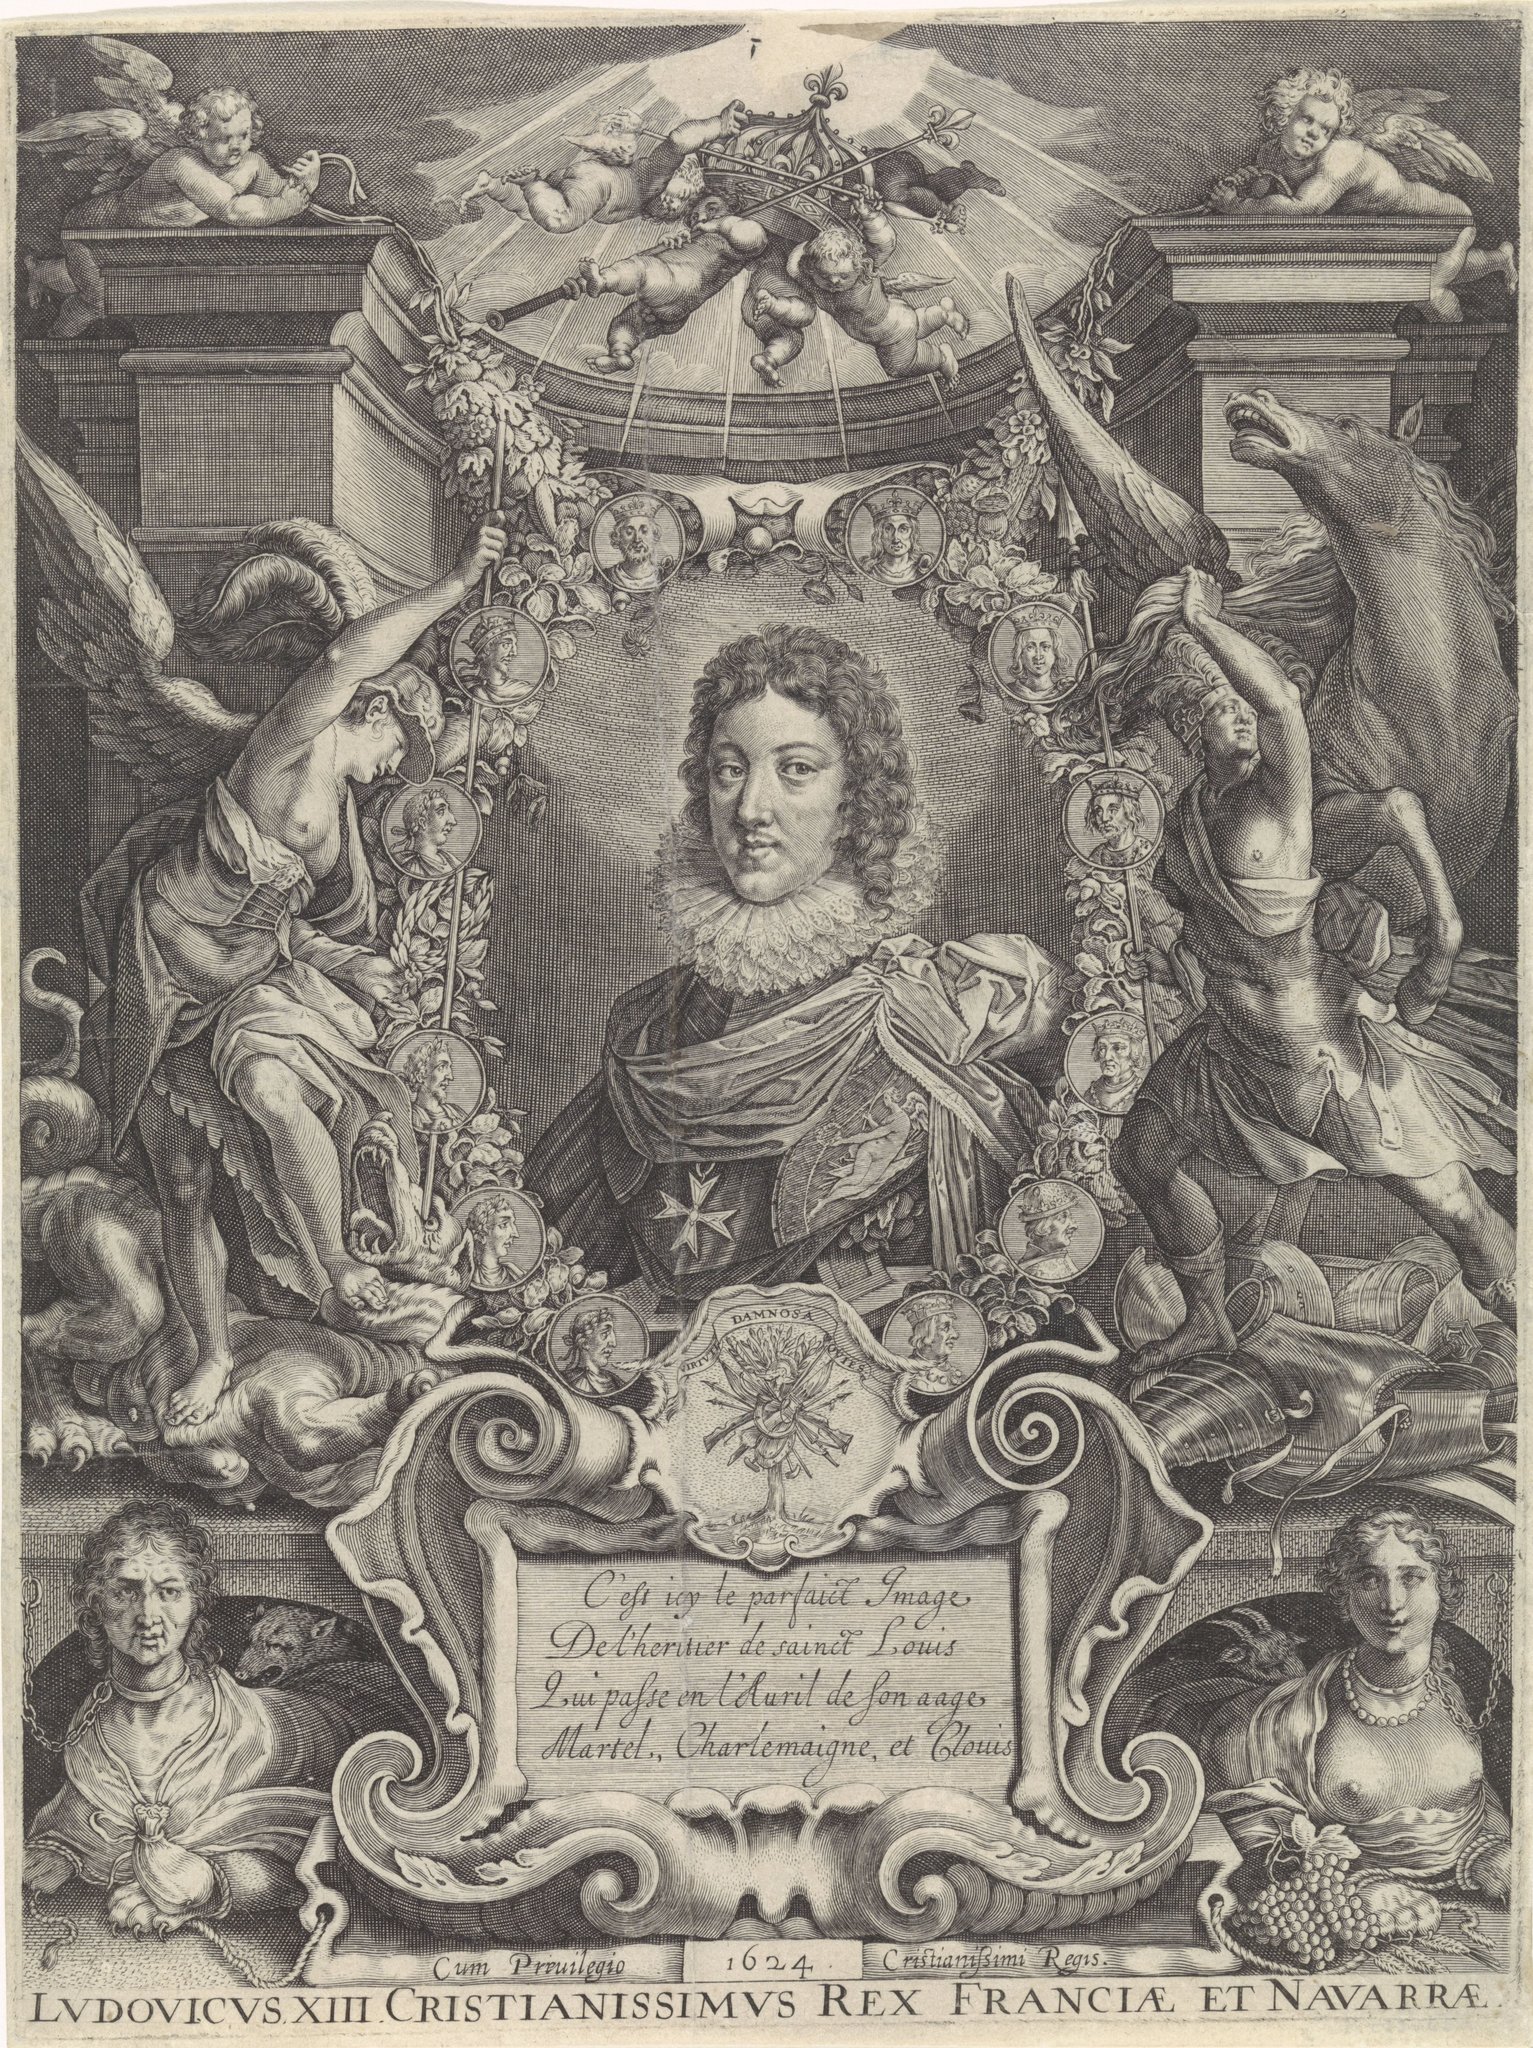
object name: print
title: Busteportret van Lodewijk XIII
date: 1624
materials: paper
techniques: engraving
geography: paris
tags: lodewijk xiii (koning van frankrijk), pegasus, the winged horse, crown (symbol of sovereignty), the archangel michael (often in armour with sword or lance), knighthood order of the holy spirit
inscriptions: date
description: Busteportret van Lodewijk XIII, koning van Frankrijk. Hij draagt een Ordeketting van de Orde van de Heilige Geest. Zijn portret is gevat in een omlijsting met de portretten van zijn voorgangers en zijn wapenschild met zijn devies in het Latijn. Het portret wordt geflankeerd door de aartsengel Michaël die in gevecht is met de draak en een Romeinse soldaat die trekt aan de manen van Pegasus. In een cartouche een vierregelig lofdicht in het Frans. In de marge de naam en functie van de geportretteerde in het Latijn.